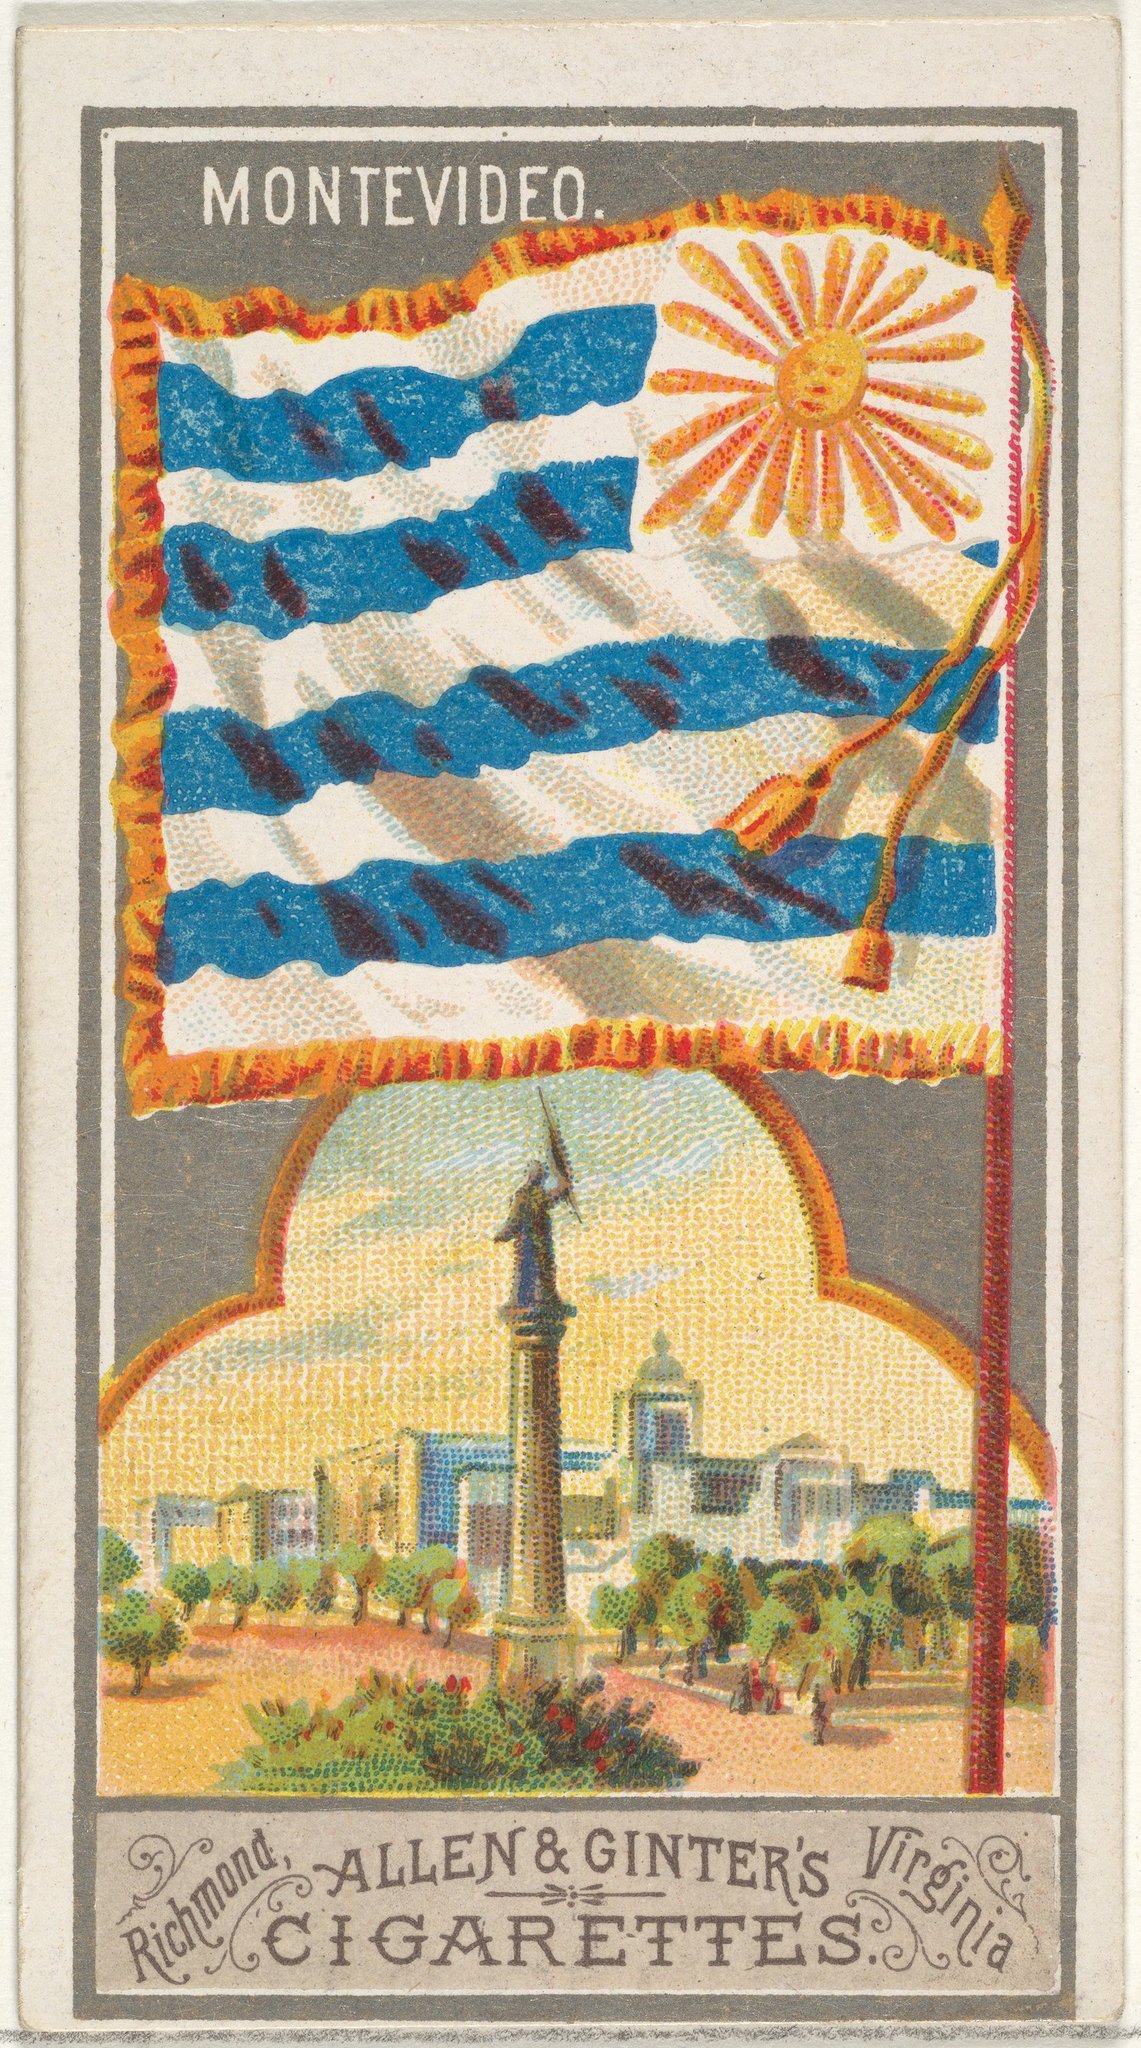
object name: print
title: Montevideo, from the City Flags series (N6) for Allen & Ginter Cigarettes Brands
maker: allen & ginter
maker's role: publisher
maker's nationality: american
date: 1887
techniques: color lithograph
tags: flags